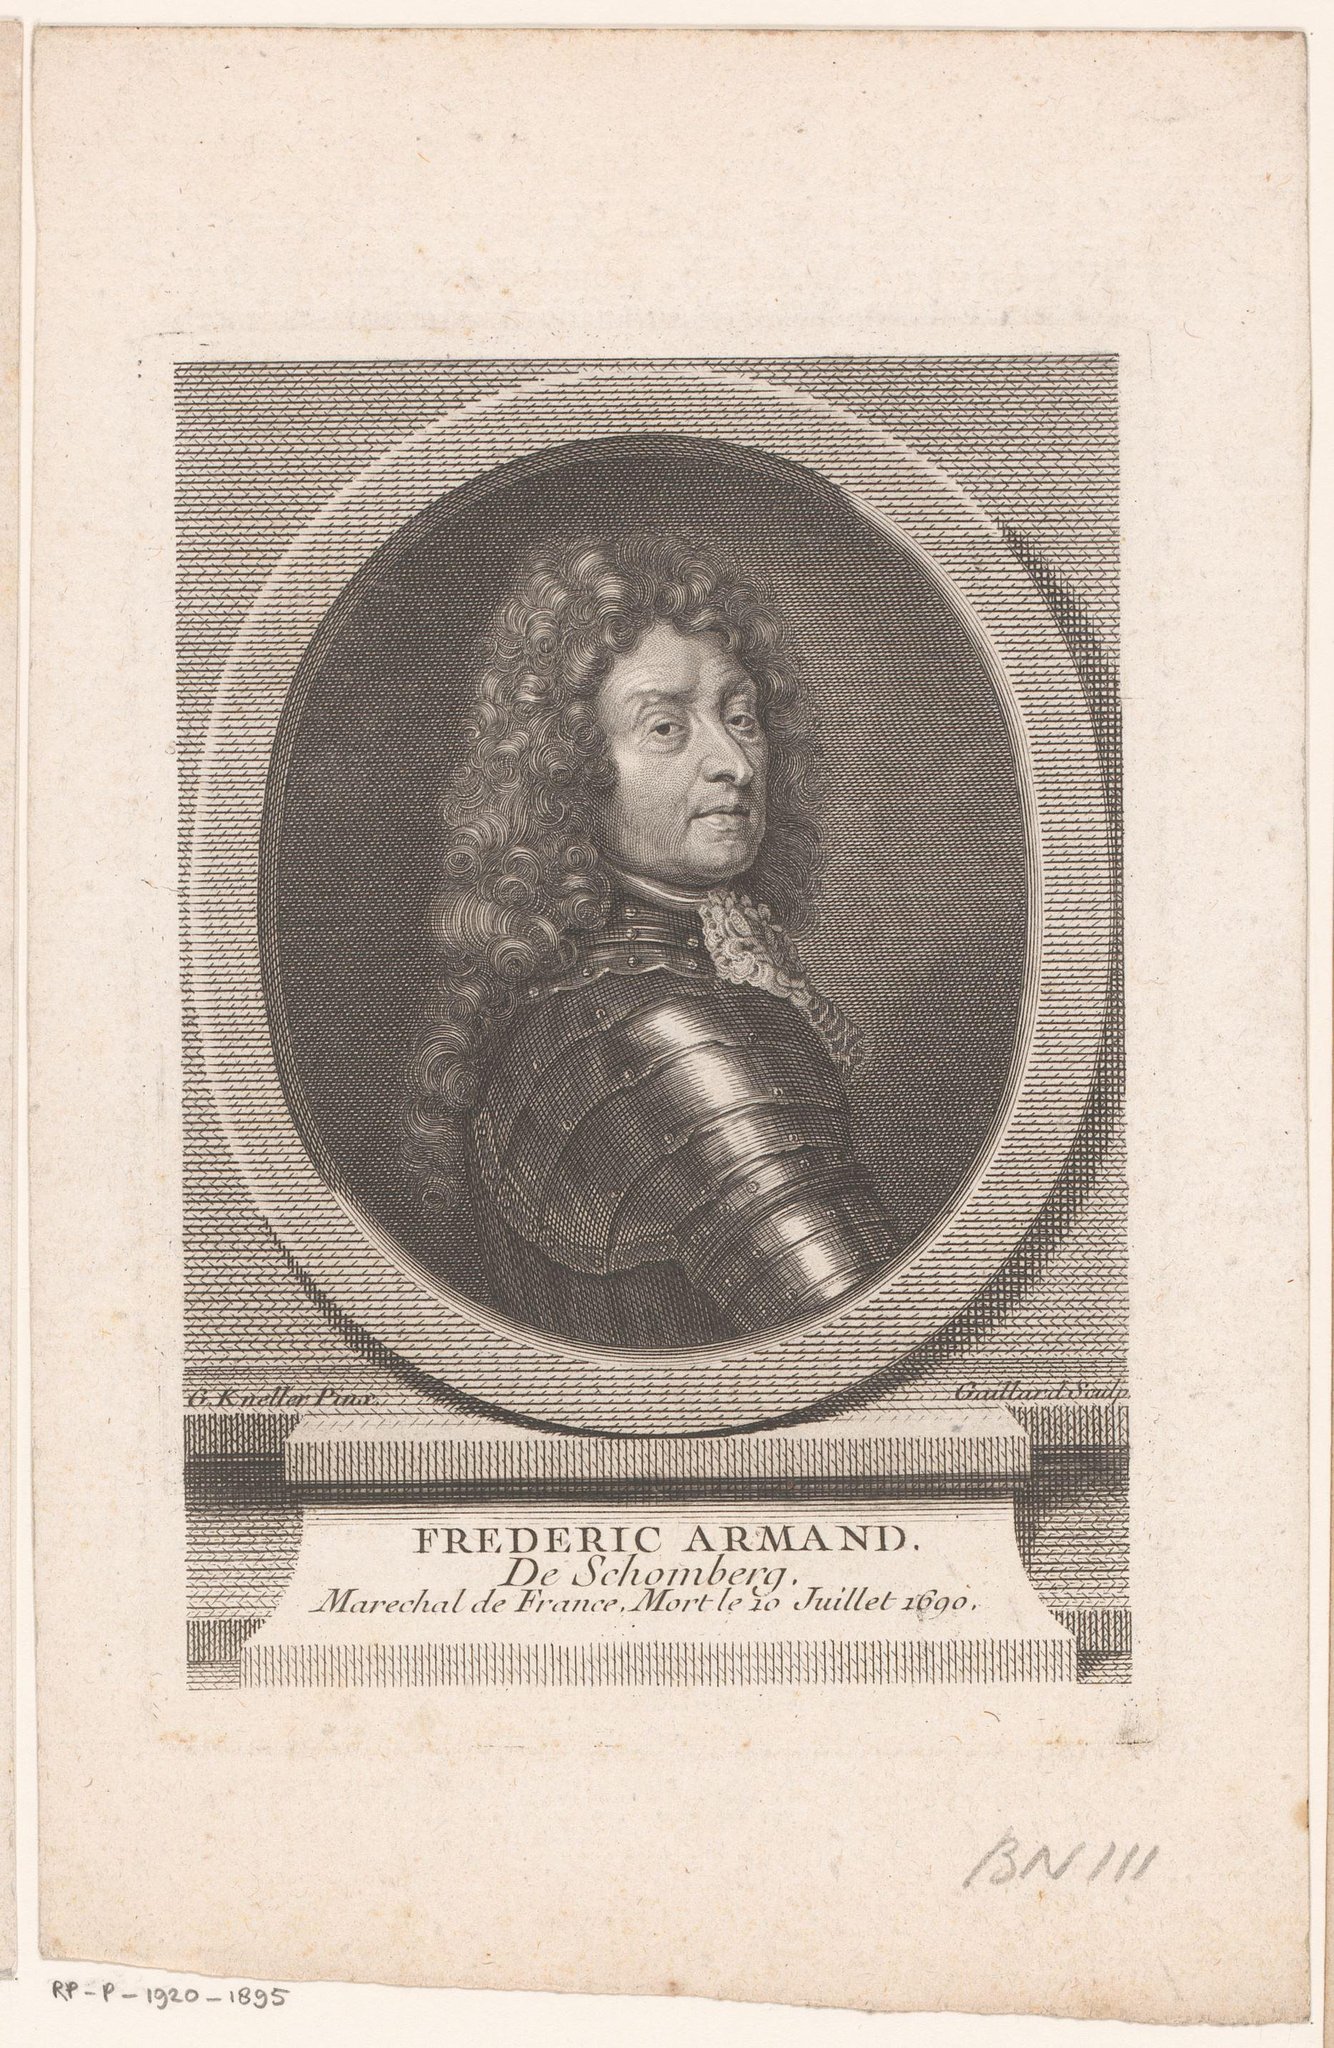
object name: book illustration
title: Portret van Friedrich Arnaud hertog van Schomberg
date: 1755-1765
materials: paper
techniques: engraving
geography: paris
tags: historical persons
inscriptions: collector's mark: Lugt 2228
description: Mogelijk prent uit: Dreux du Radier, Jean-François. L'Europe illustré, contenant l'histoire abregée des souverains, des princes, des prélats, des ministres, (...) en Europe: dans le XVe. siècle compris, jusqu'à présent. Parijs: Michel Odieuvre en André-François Le Breton, 1755-1765, dl. 4.